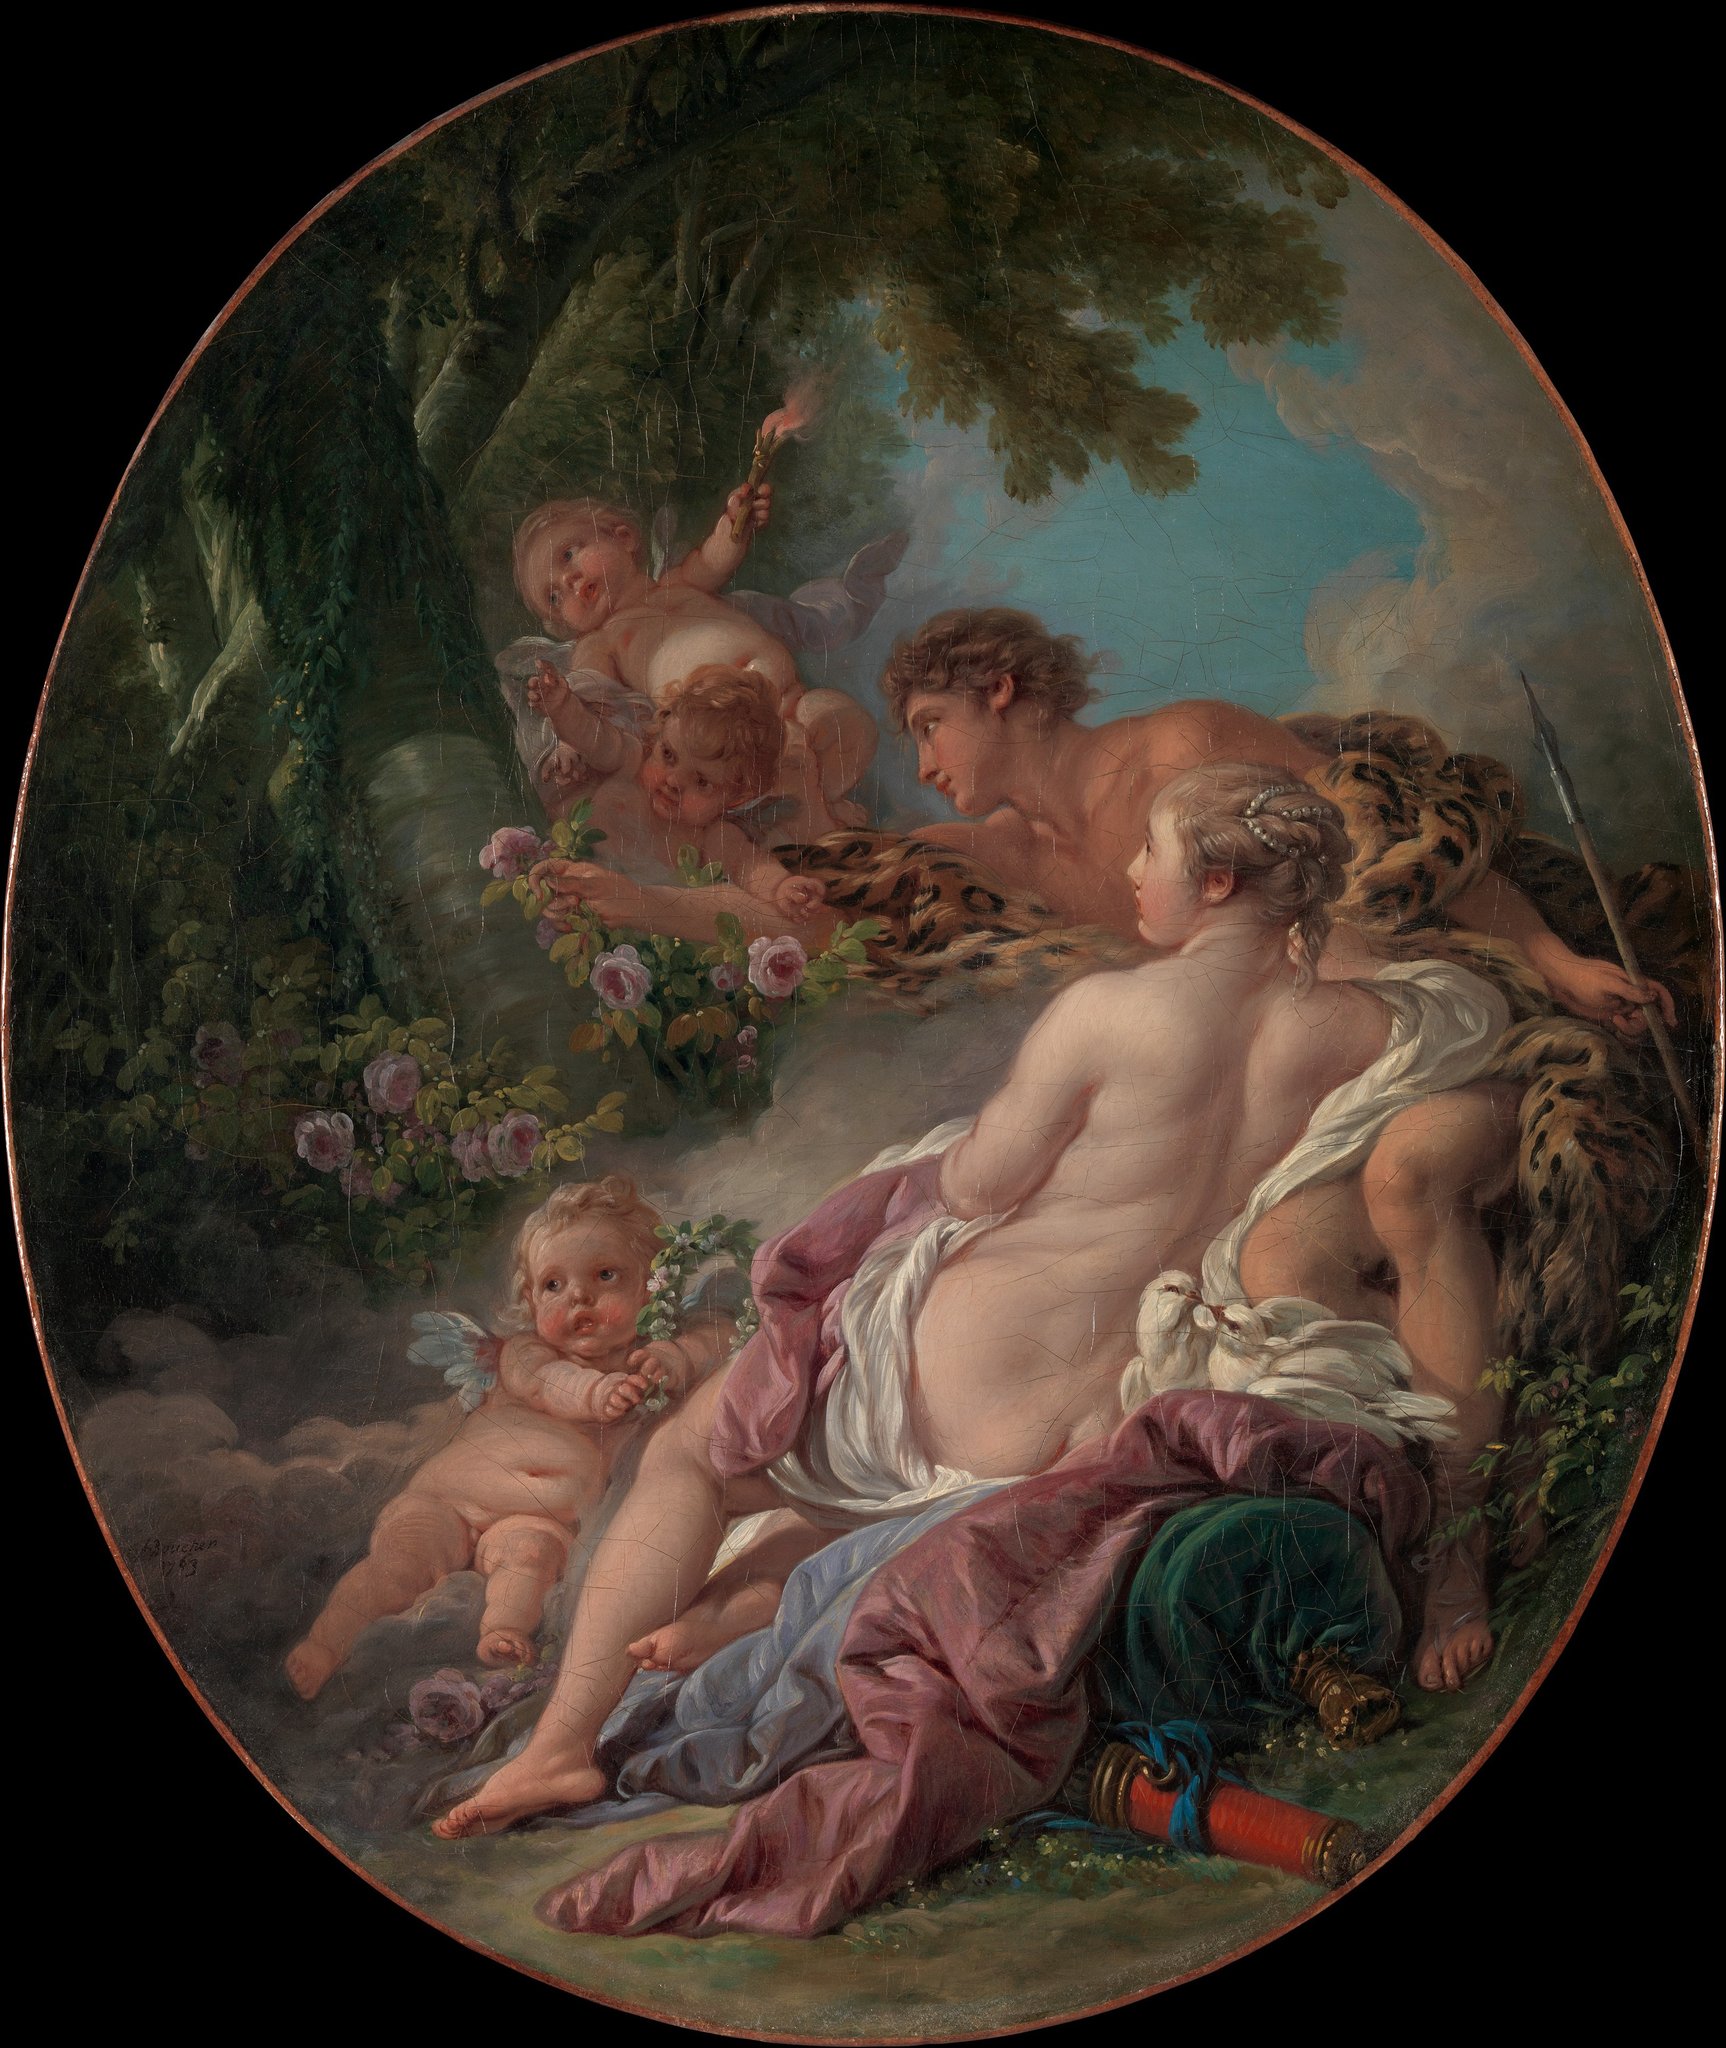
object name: painting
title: Angelica and Medoro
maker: françois boucher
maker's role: artist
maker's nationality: french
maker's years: 1703-1770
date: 1763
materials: canvas, oil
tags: female nudes,putti